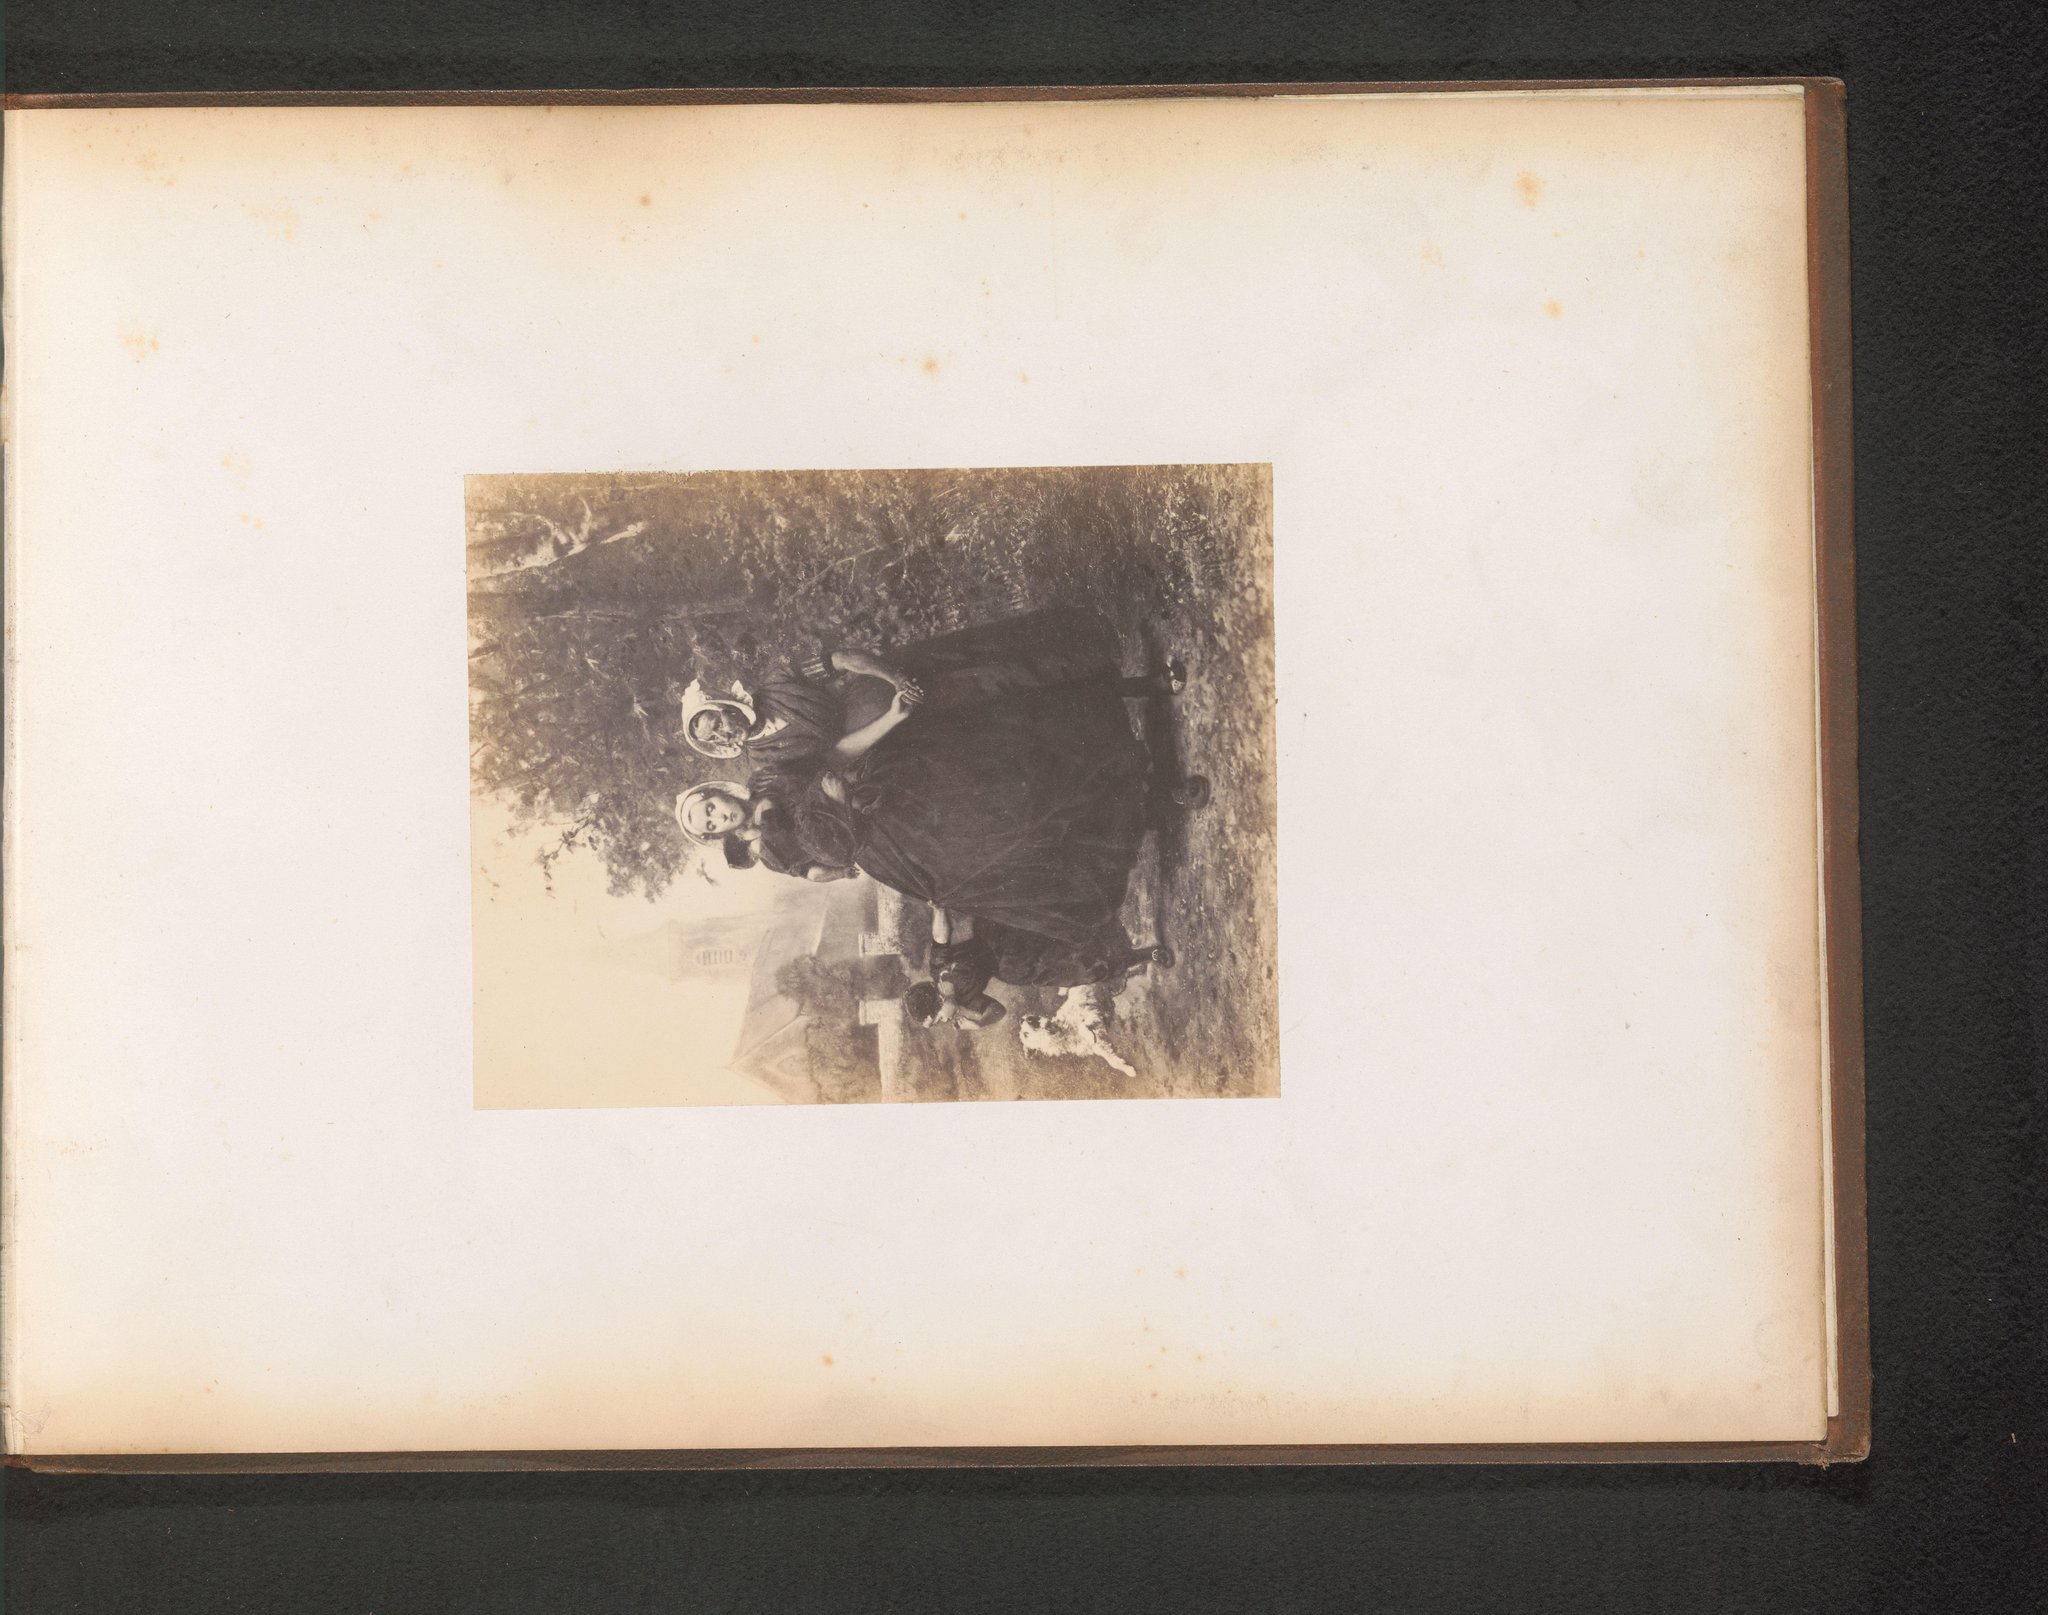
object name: photograph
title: Fotoreproductie van La Veuve van Adolphe Alexander Dillens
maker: Anonymous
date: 1858-1863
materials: photographic support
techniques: albumen print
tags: adult woman, picture, painting, dog